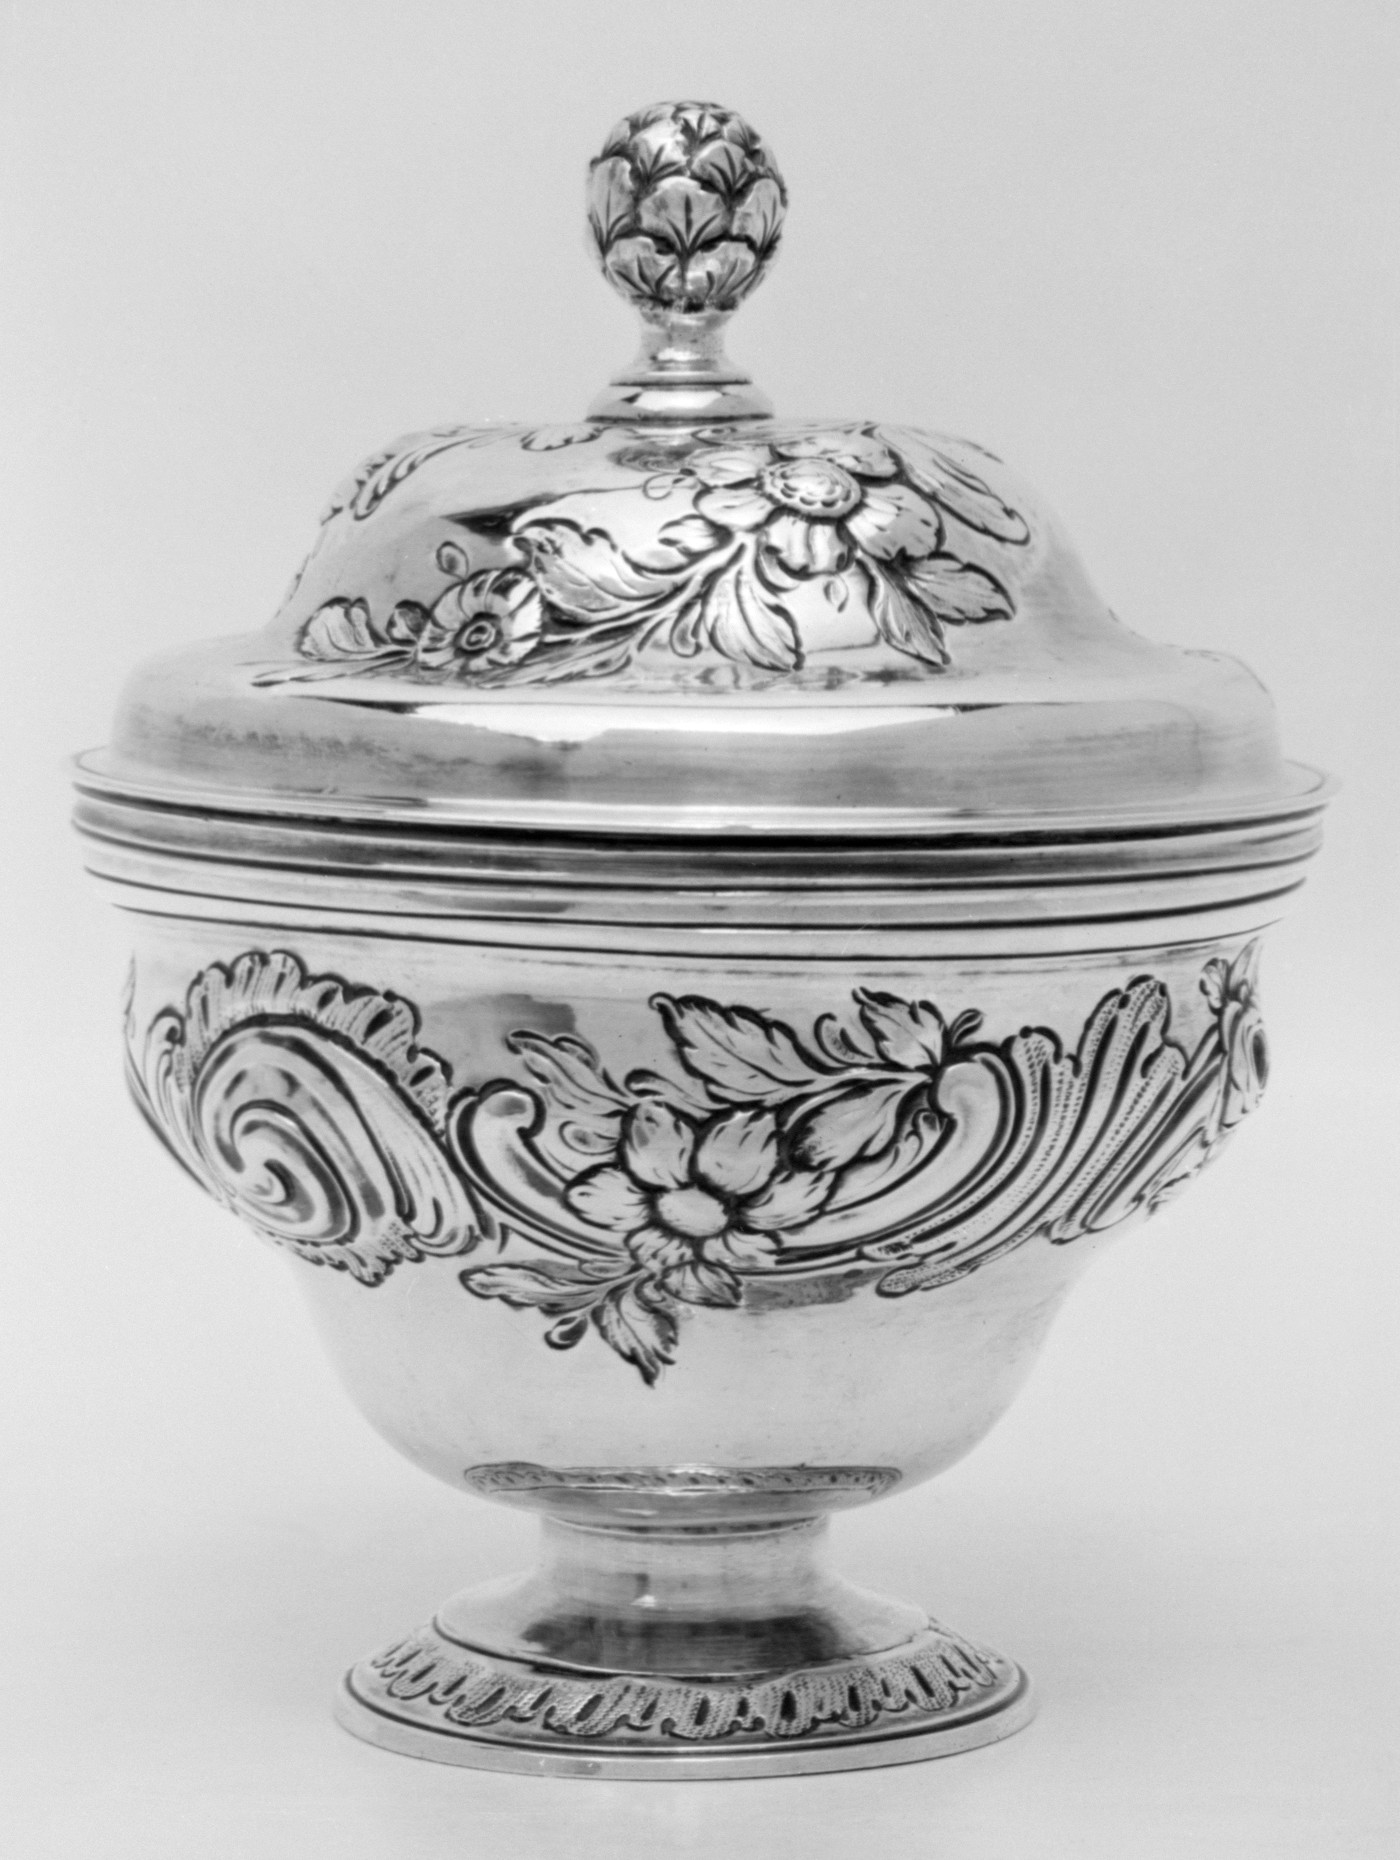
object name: sugar bowl with cover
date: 1758-1759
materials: silver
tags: flowers